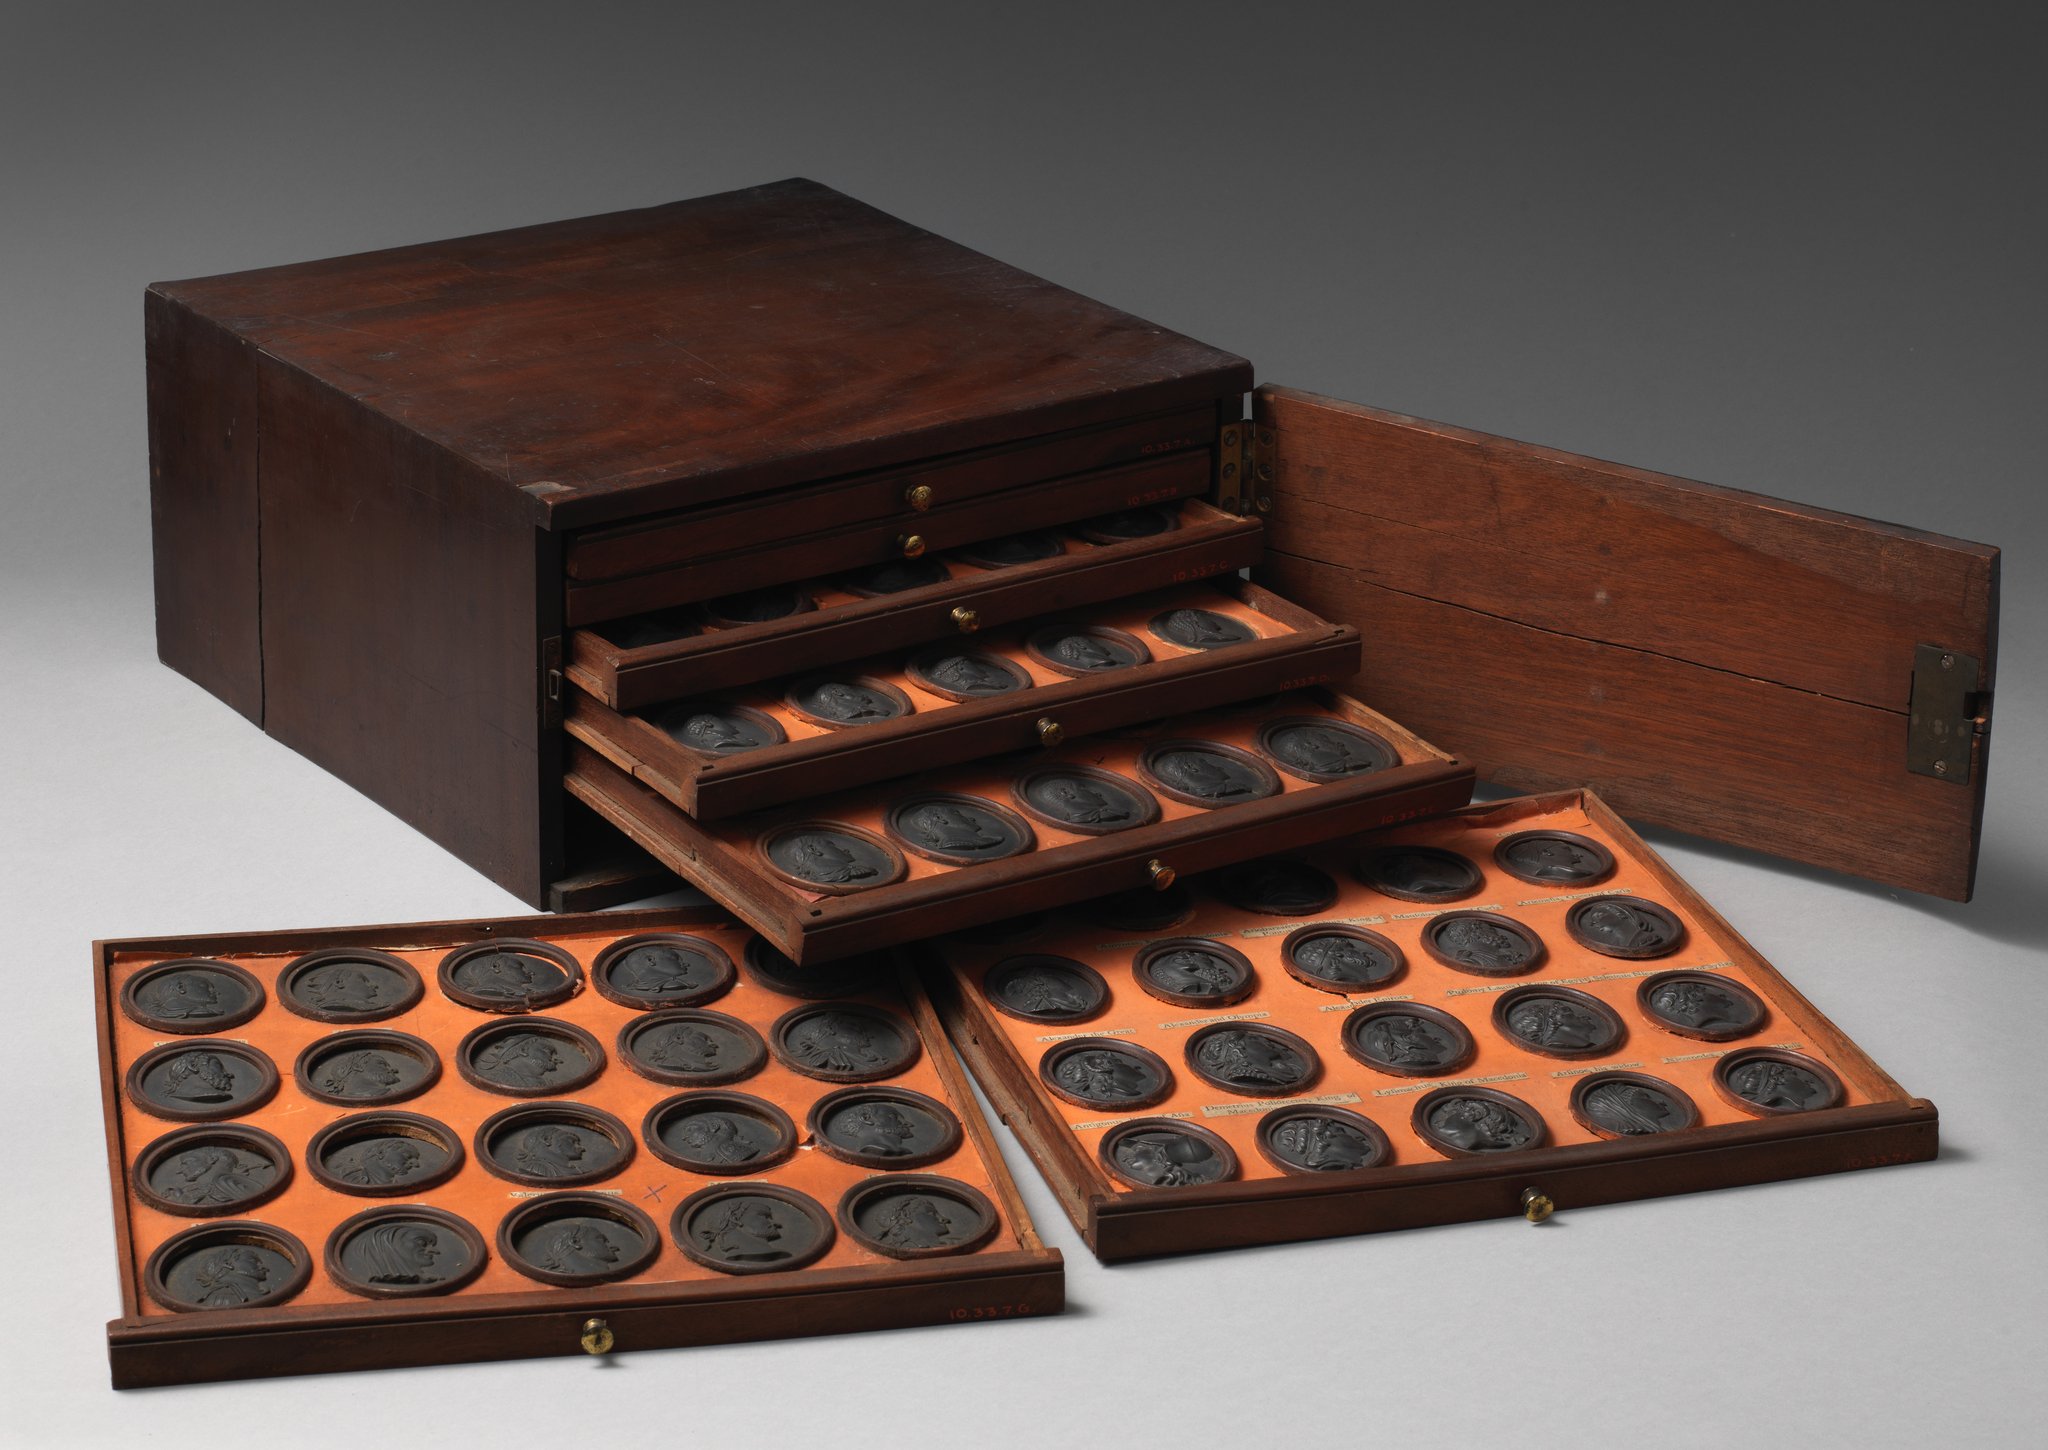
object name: cabinet of plaque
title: Cabinet of 140 plaques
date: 1701-1800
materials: stone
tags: men,profiles